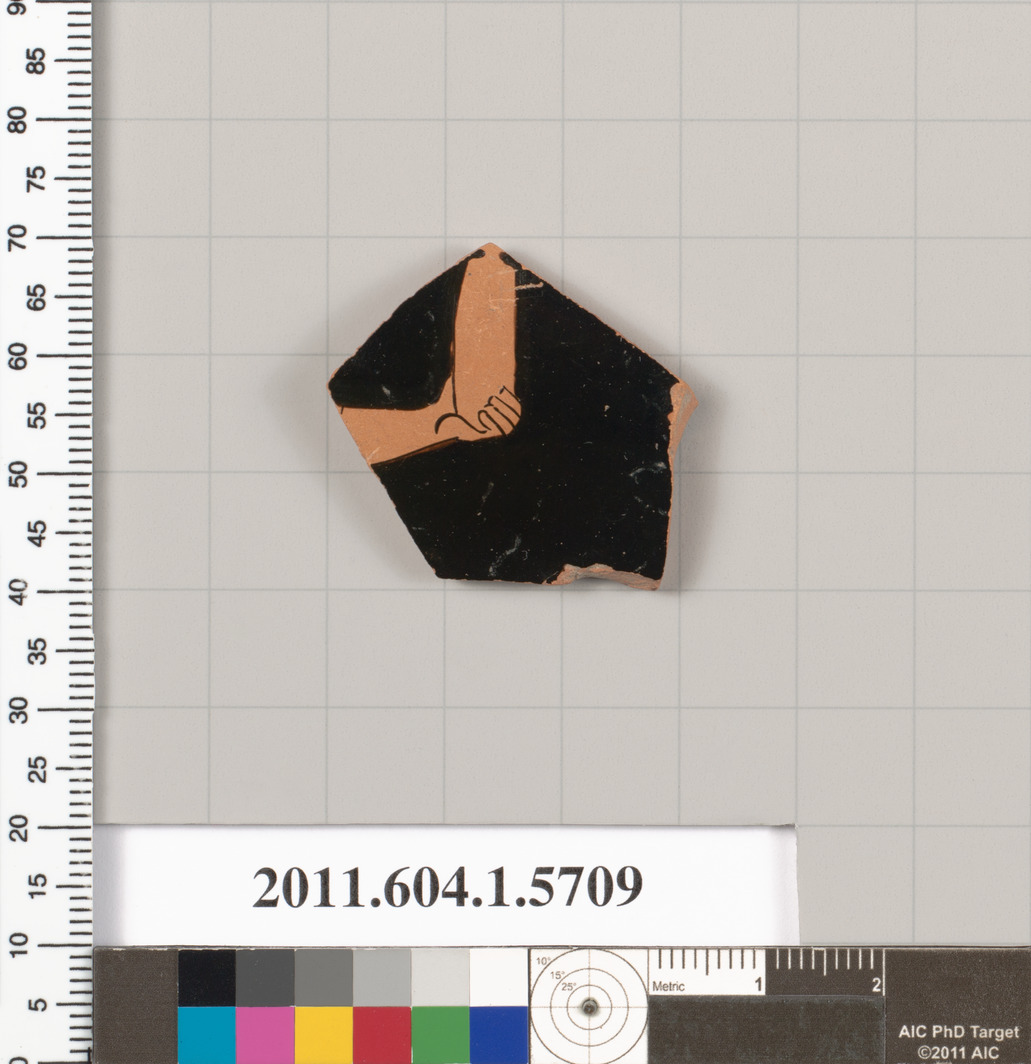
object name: kylix fragment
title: Terracotta fragment of a kylix (drinking cup)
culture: greek, attic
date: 490-470 BCE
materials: terracotta